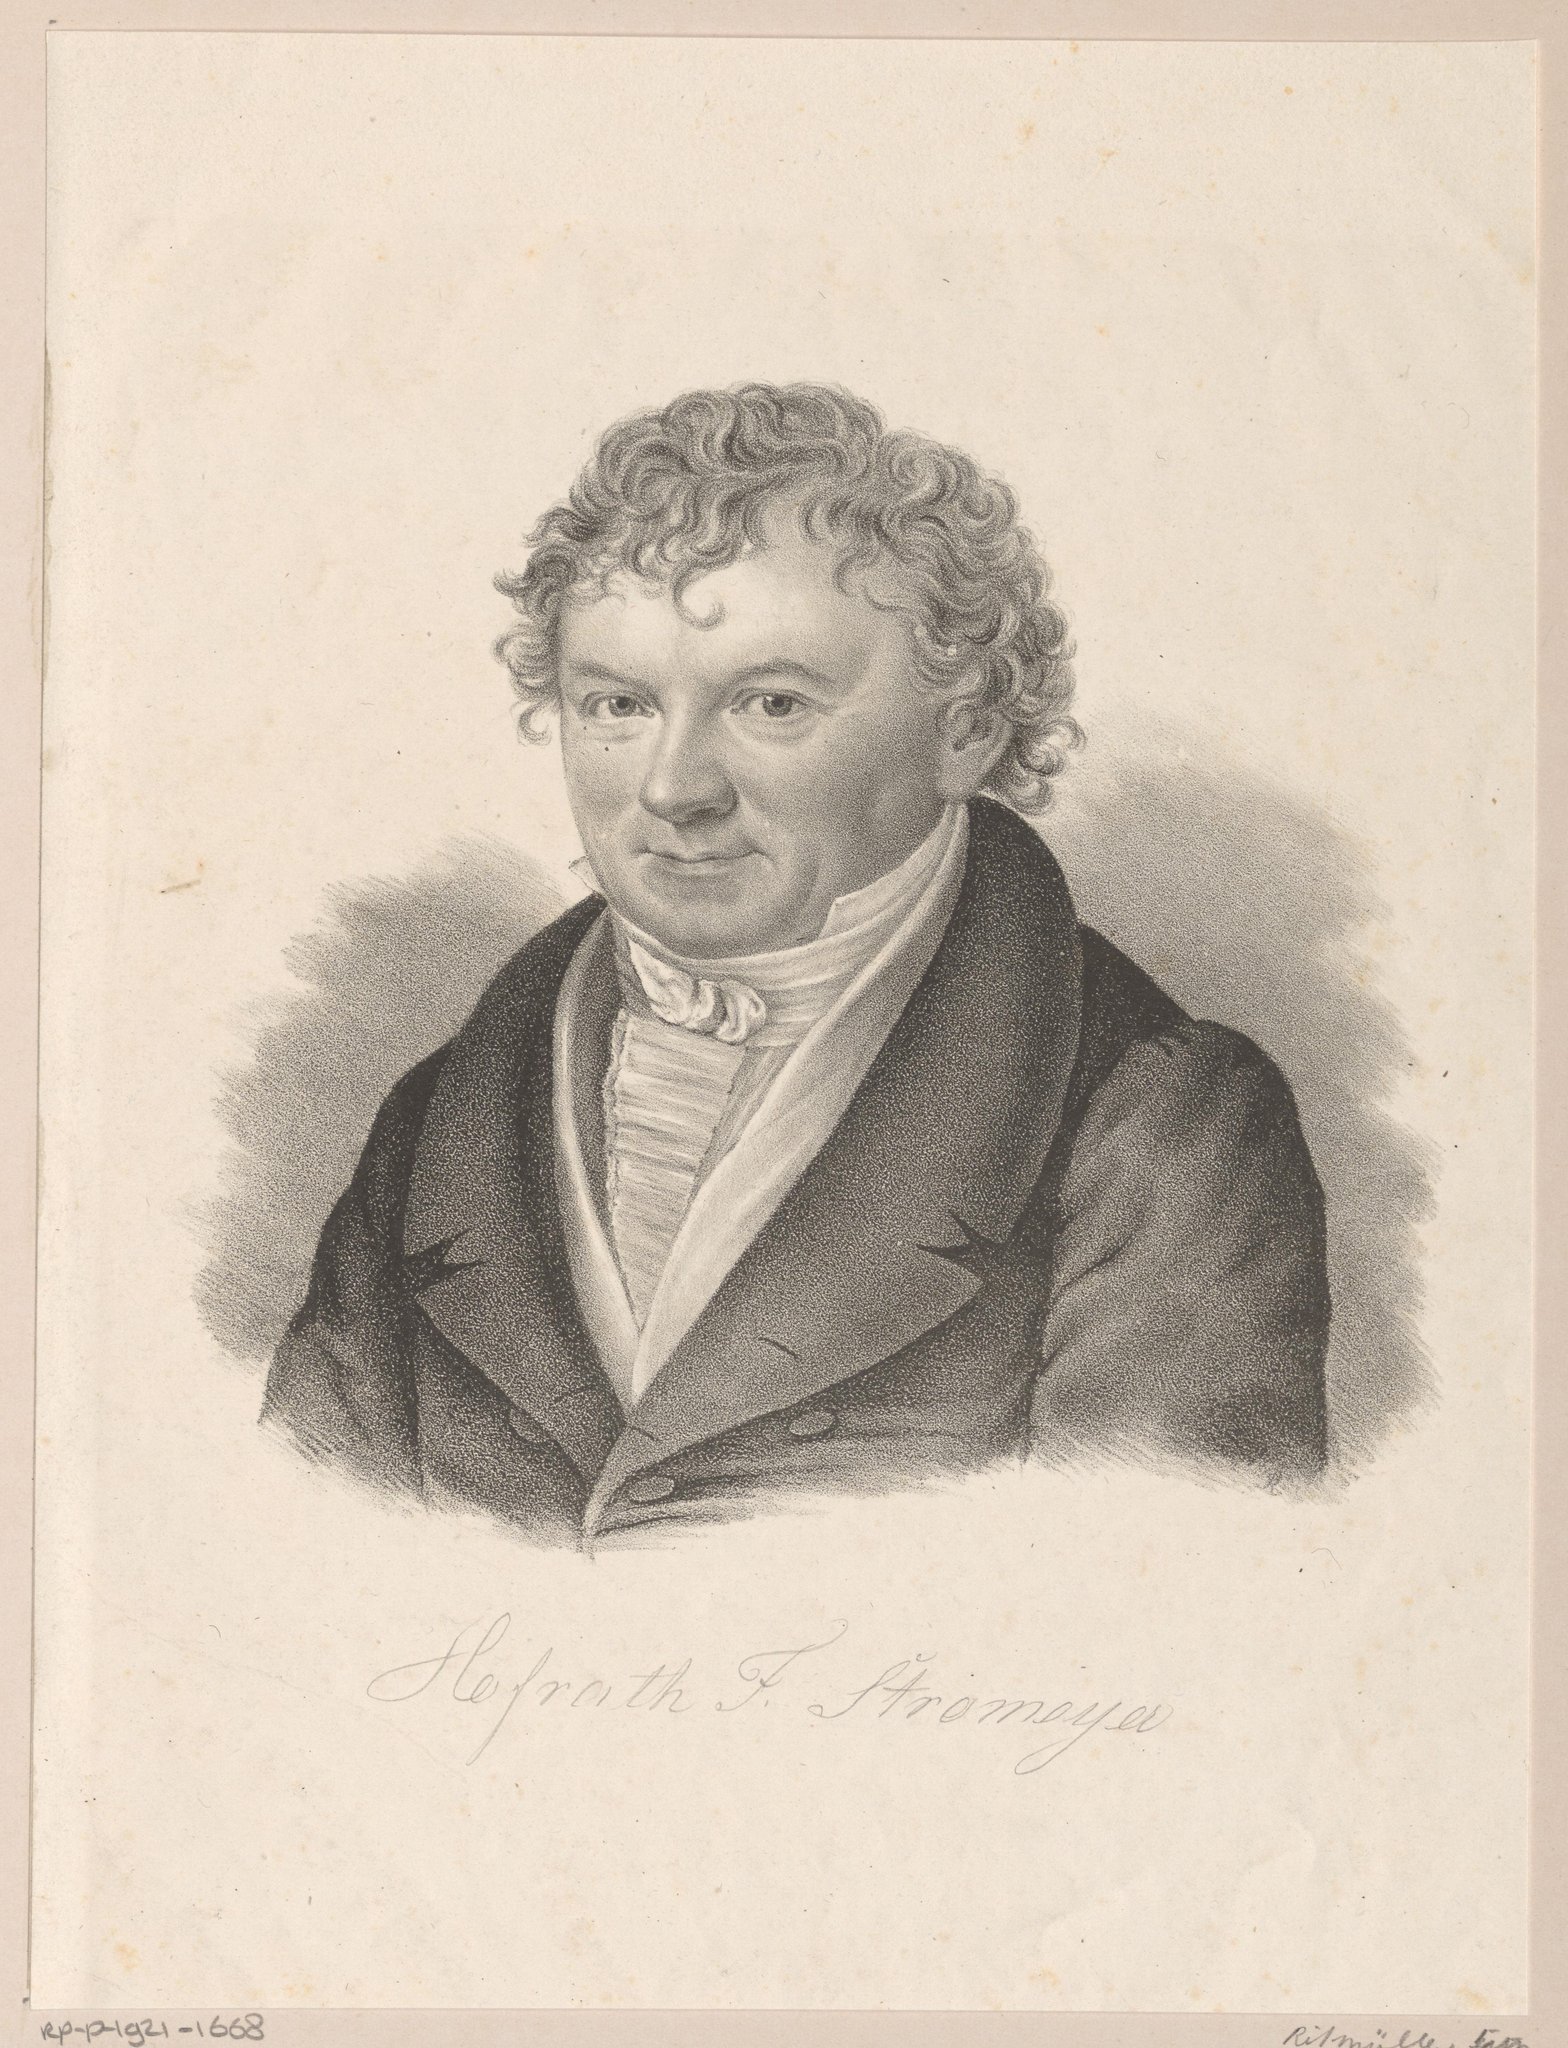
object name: print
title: Portret van Friedrich Stromeyer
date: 1857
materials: paper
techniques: lithograph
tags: chemistry (+ portrait of scholar, scientist), historical persons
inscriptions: inscription: ‘Hofrath F. Stromeyer’, collector's mark: Lugt 2233